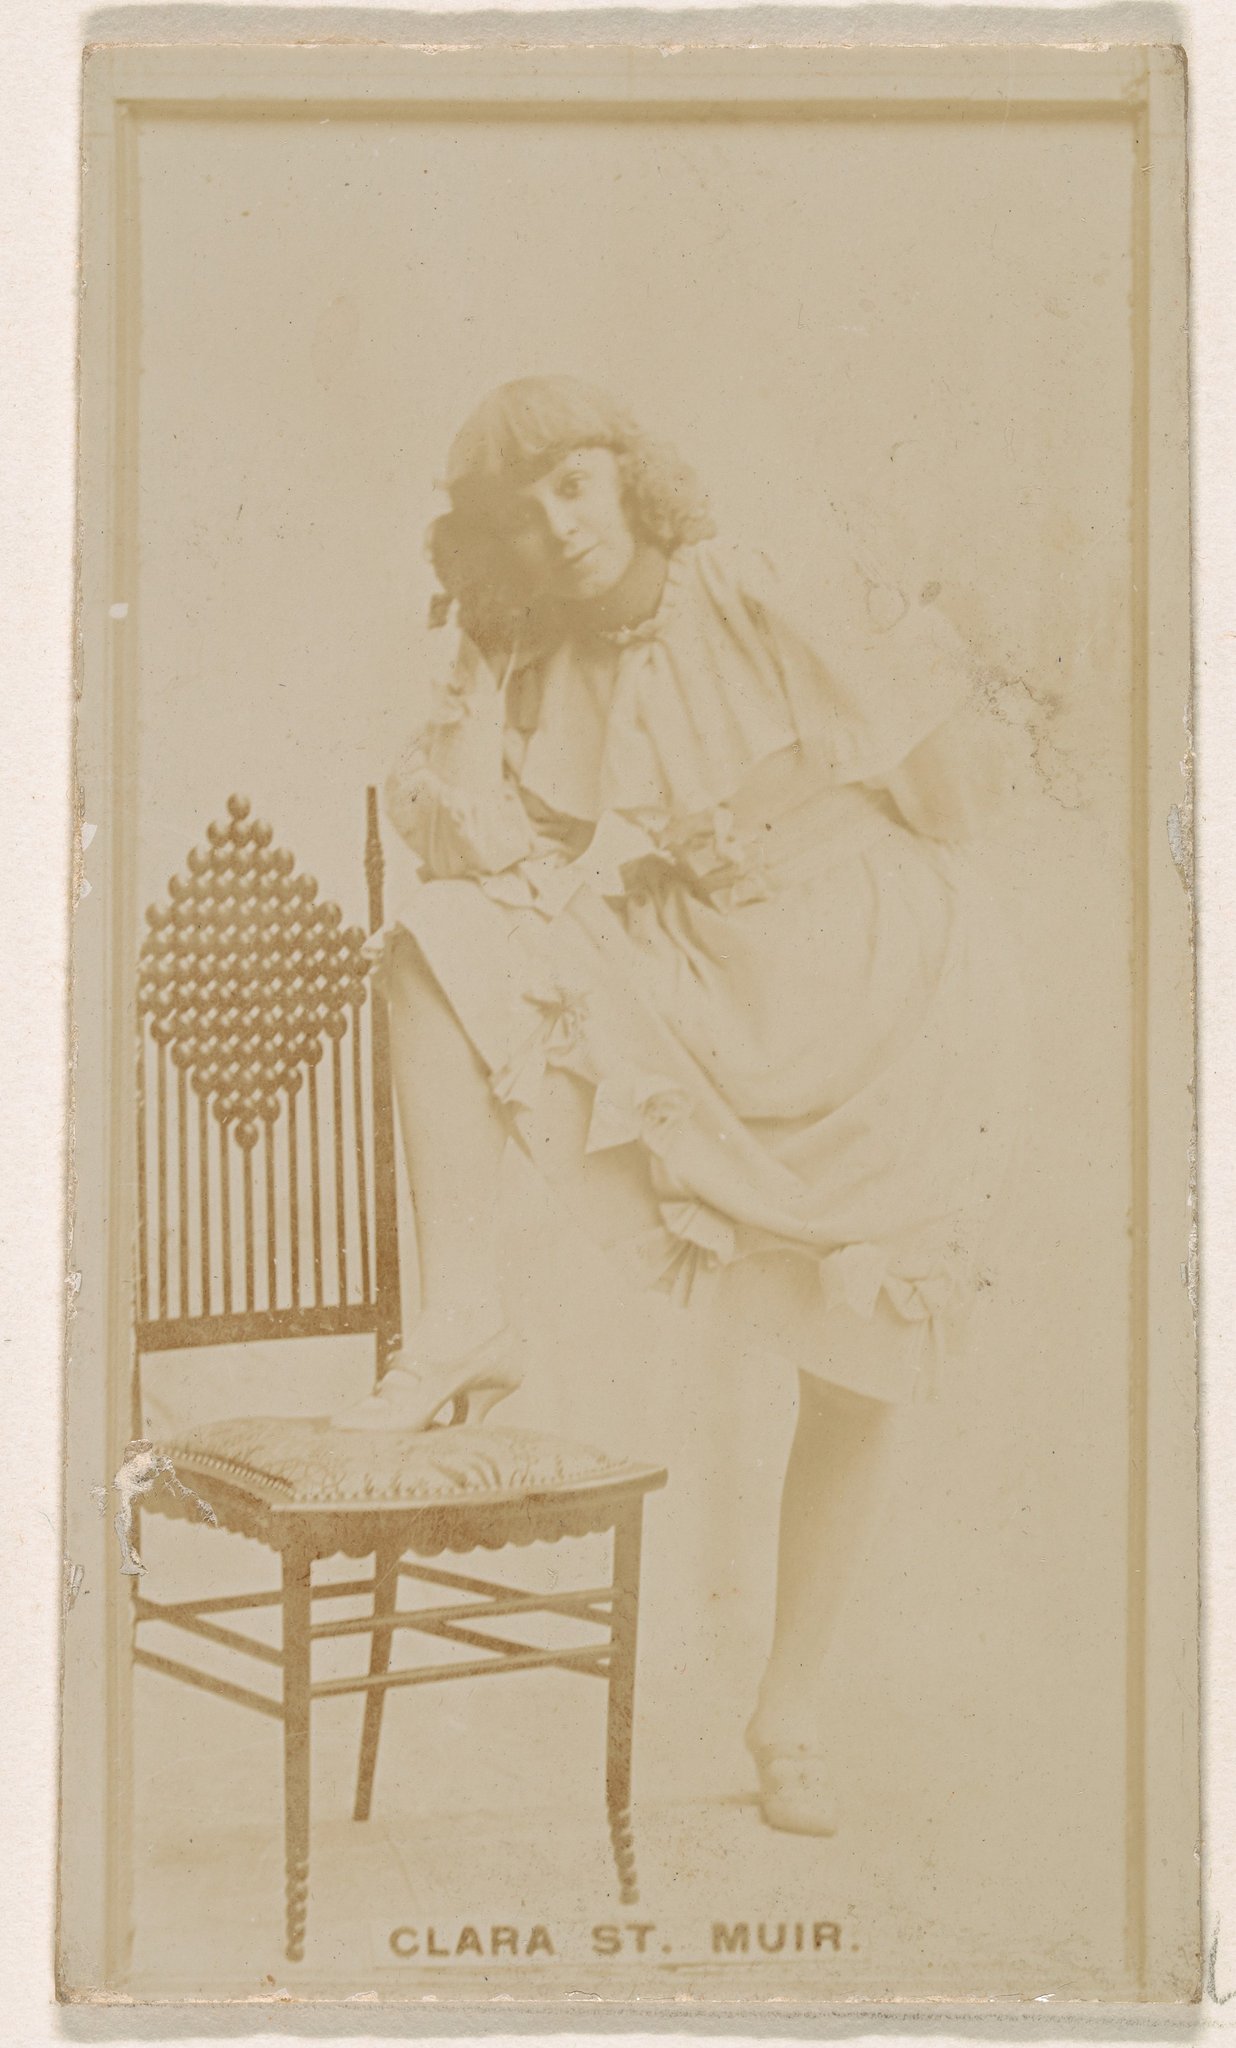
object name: photograph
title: Clara St. Muir, from the Actresses series (N245) issued by Kinney Brothers to promote Sweet Caporal Cigarettes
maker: kinney brothers tobacco company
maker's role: publisher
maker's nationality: american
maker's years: 1869-2011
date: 1890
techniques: albumen silver print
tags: portraits,women,actresses